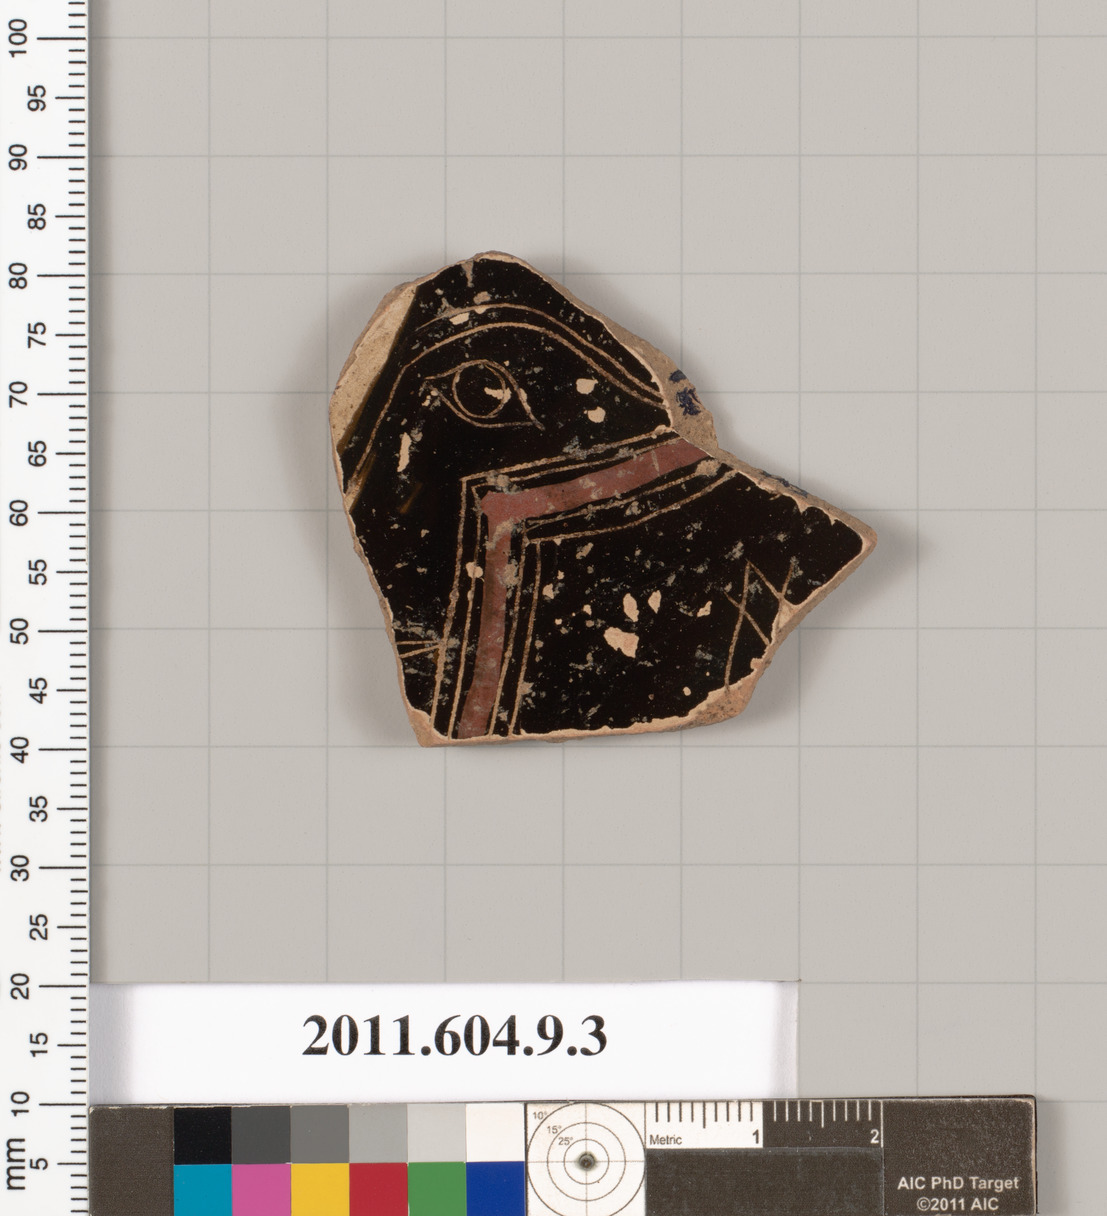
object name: kylix fragment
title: Terracotta fragment of a kylix (drinking cup)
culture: greek, laconian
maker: typhon painter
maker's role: artist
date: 560-550 BCE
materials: terracotta